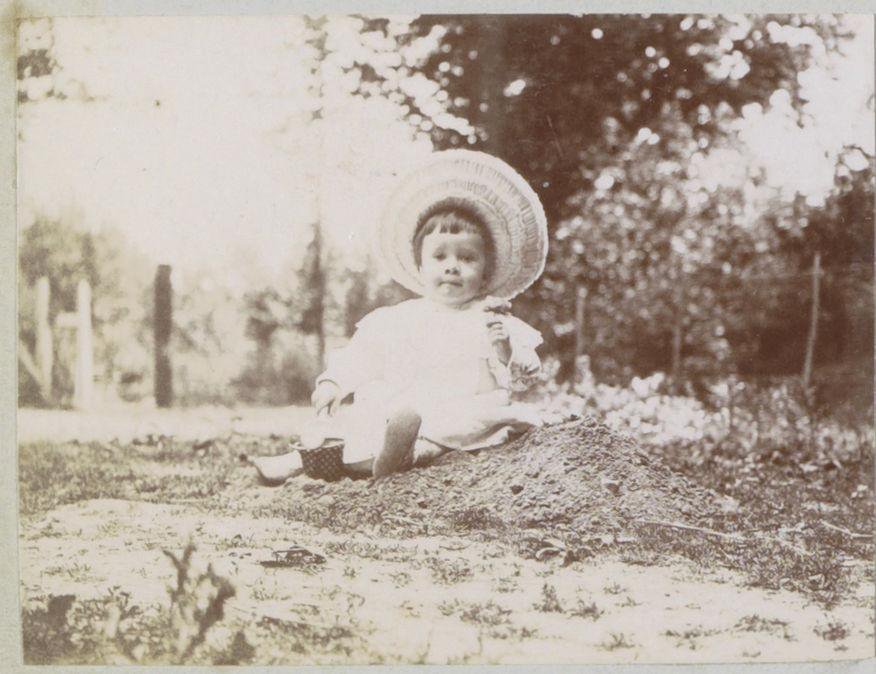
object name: photograph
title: Portret van een peuter, spelend met schep en vorm, vermoedelijk in Frankrijk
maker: delizy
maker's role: manufacturer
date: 1903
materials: paper, photographic support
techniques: gelatin silver print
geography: france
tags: head-gear: hat, (playing with) toys, tot, toddler ~ the ages of man, france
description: Onderdeel van Fotoalbum van een Franse amateurfotograaf met opnames van uitstapjes in Frankrijk, Spanje, België, Luxemburg en Nederland, de eerste automobielen en autoraces.